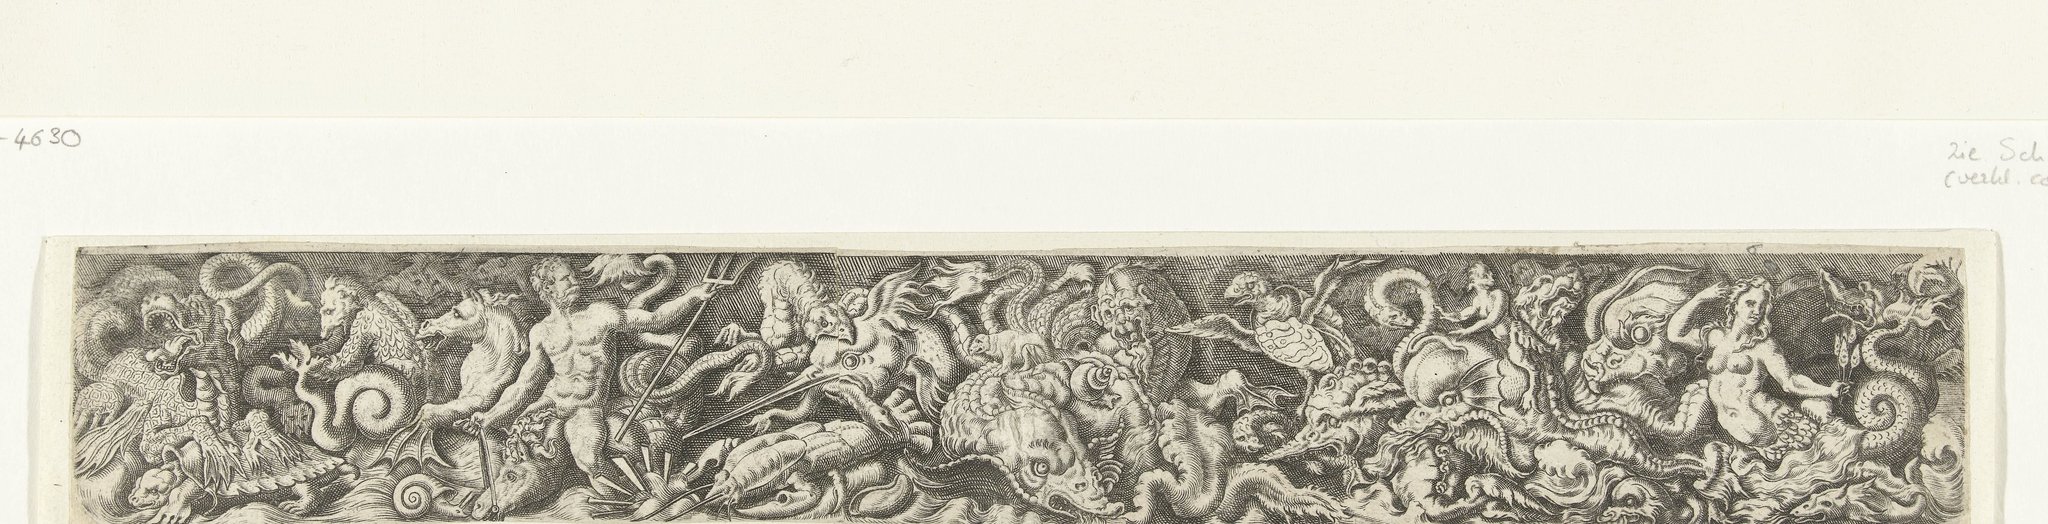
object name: print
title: Fries met de triomf van Neptunus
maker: Anonymous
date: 1548-1650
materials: paper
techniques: engraving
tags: fabulous animals (sometimes wrongly called 'grotesques'); 'mostri' (ripa), sea-horse, hippocamp, 'hippocampus', (horse/fish) (mythological hybrid monster), river-gods, triumph of neptune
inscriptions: collector's mark: Lugt 2228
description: Verschillende fabeldieren zijn met elkaar verwrongen. Links rijdt Neptunus op een hippocampus, rechts een meermin met pauwenveren in haar hand.